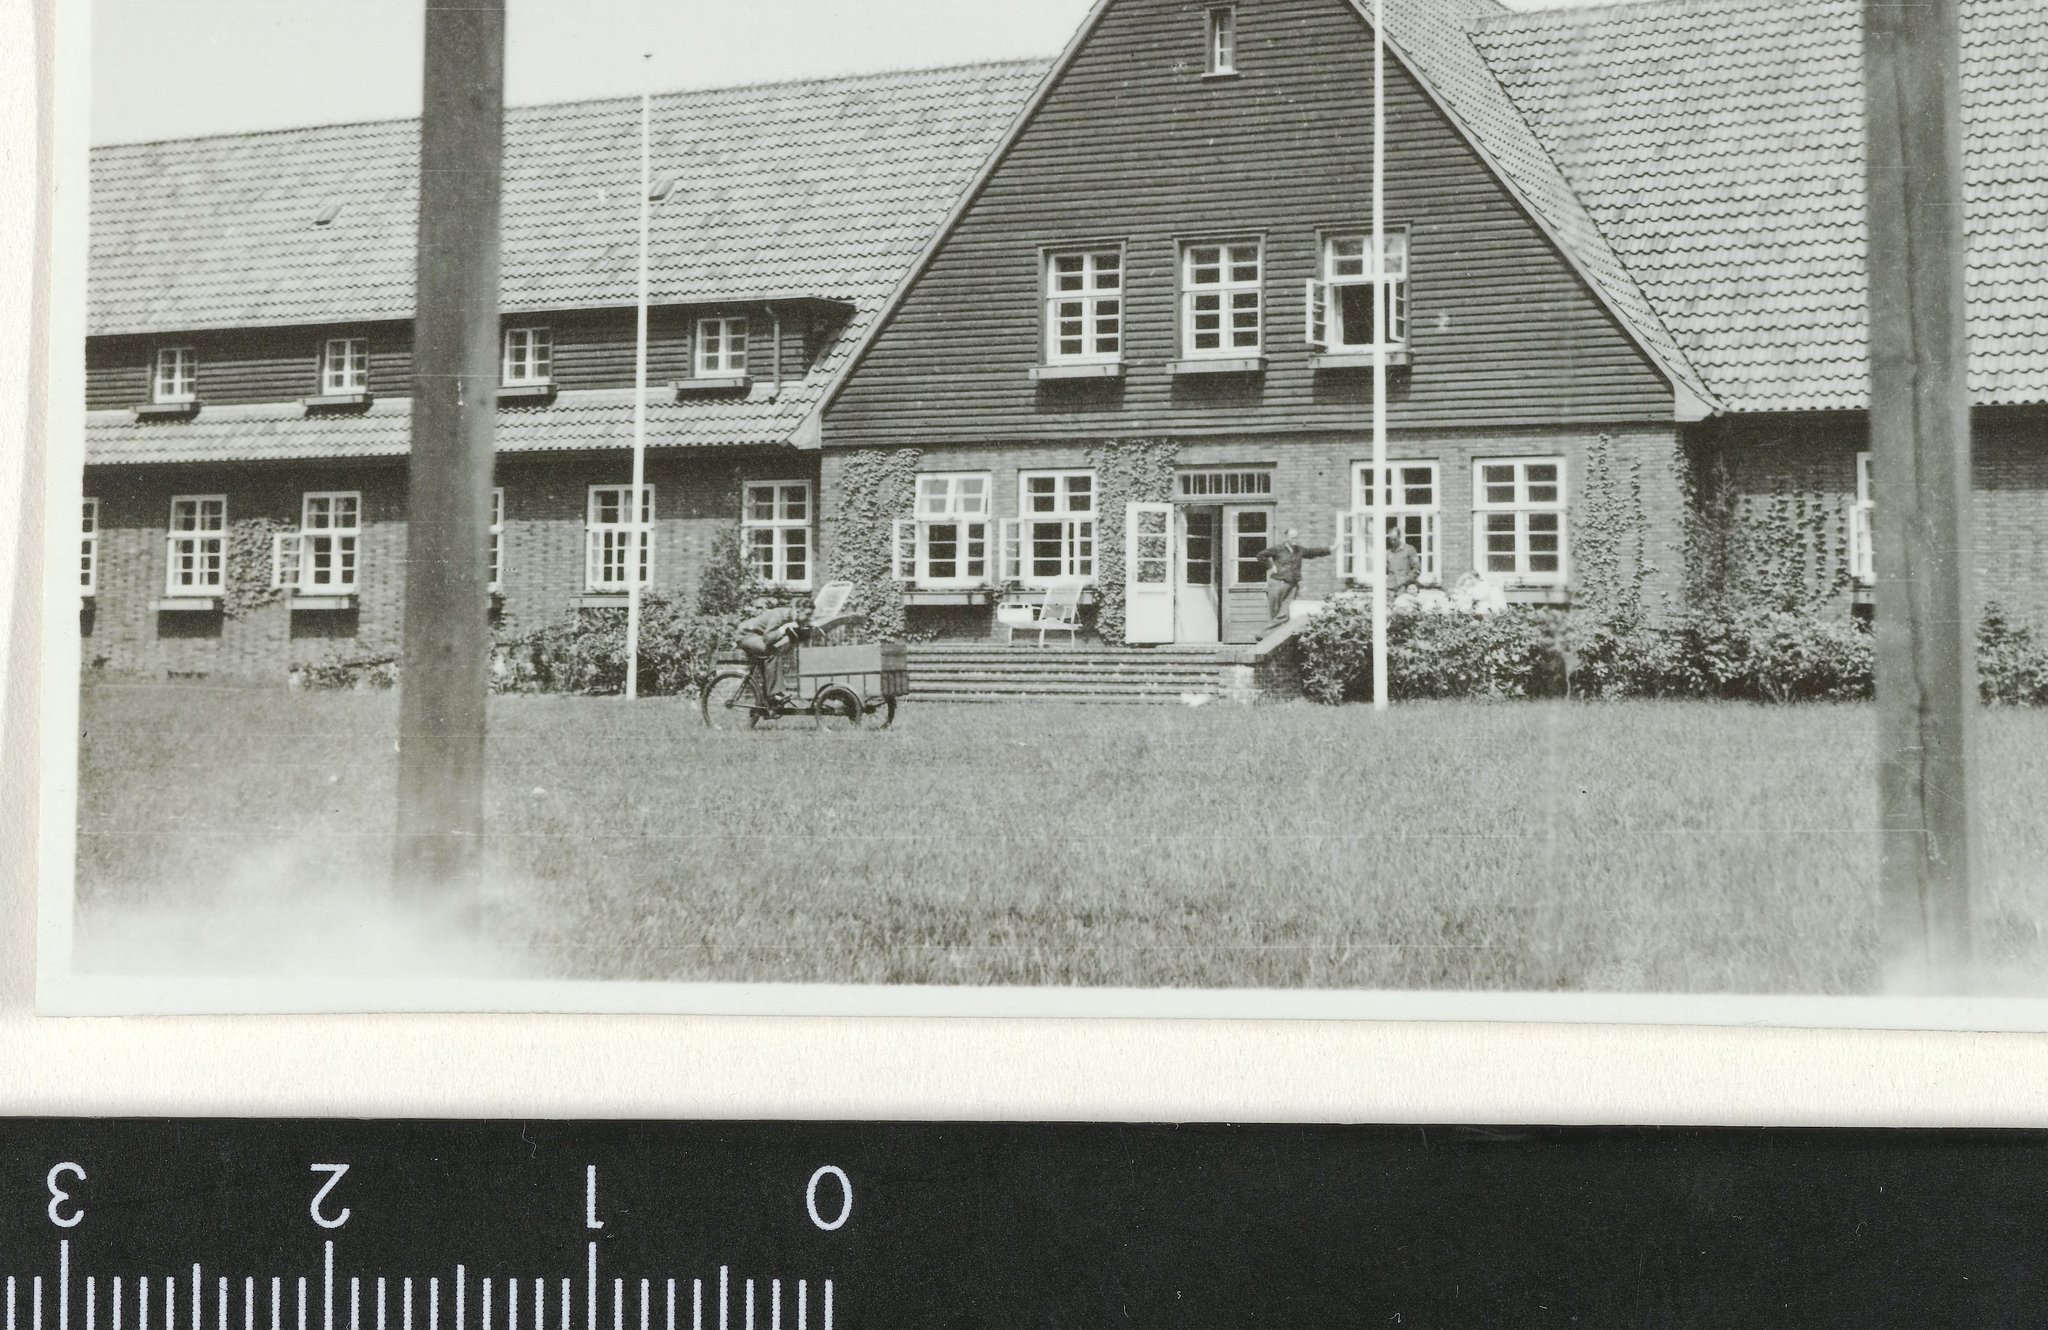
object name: photograph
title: Herstellingsoord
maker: Anonymous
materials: photographic support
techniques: gelatin silver print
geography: netherlands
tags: medical aid and nursing of the sick and wounded, occupation ~ war, netherlands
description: Een herstellingsoord voor militairen. Op de voorgrond een pergola. Voor het huis rijdt iemand op een soort bakkerskar.